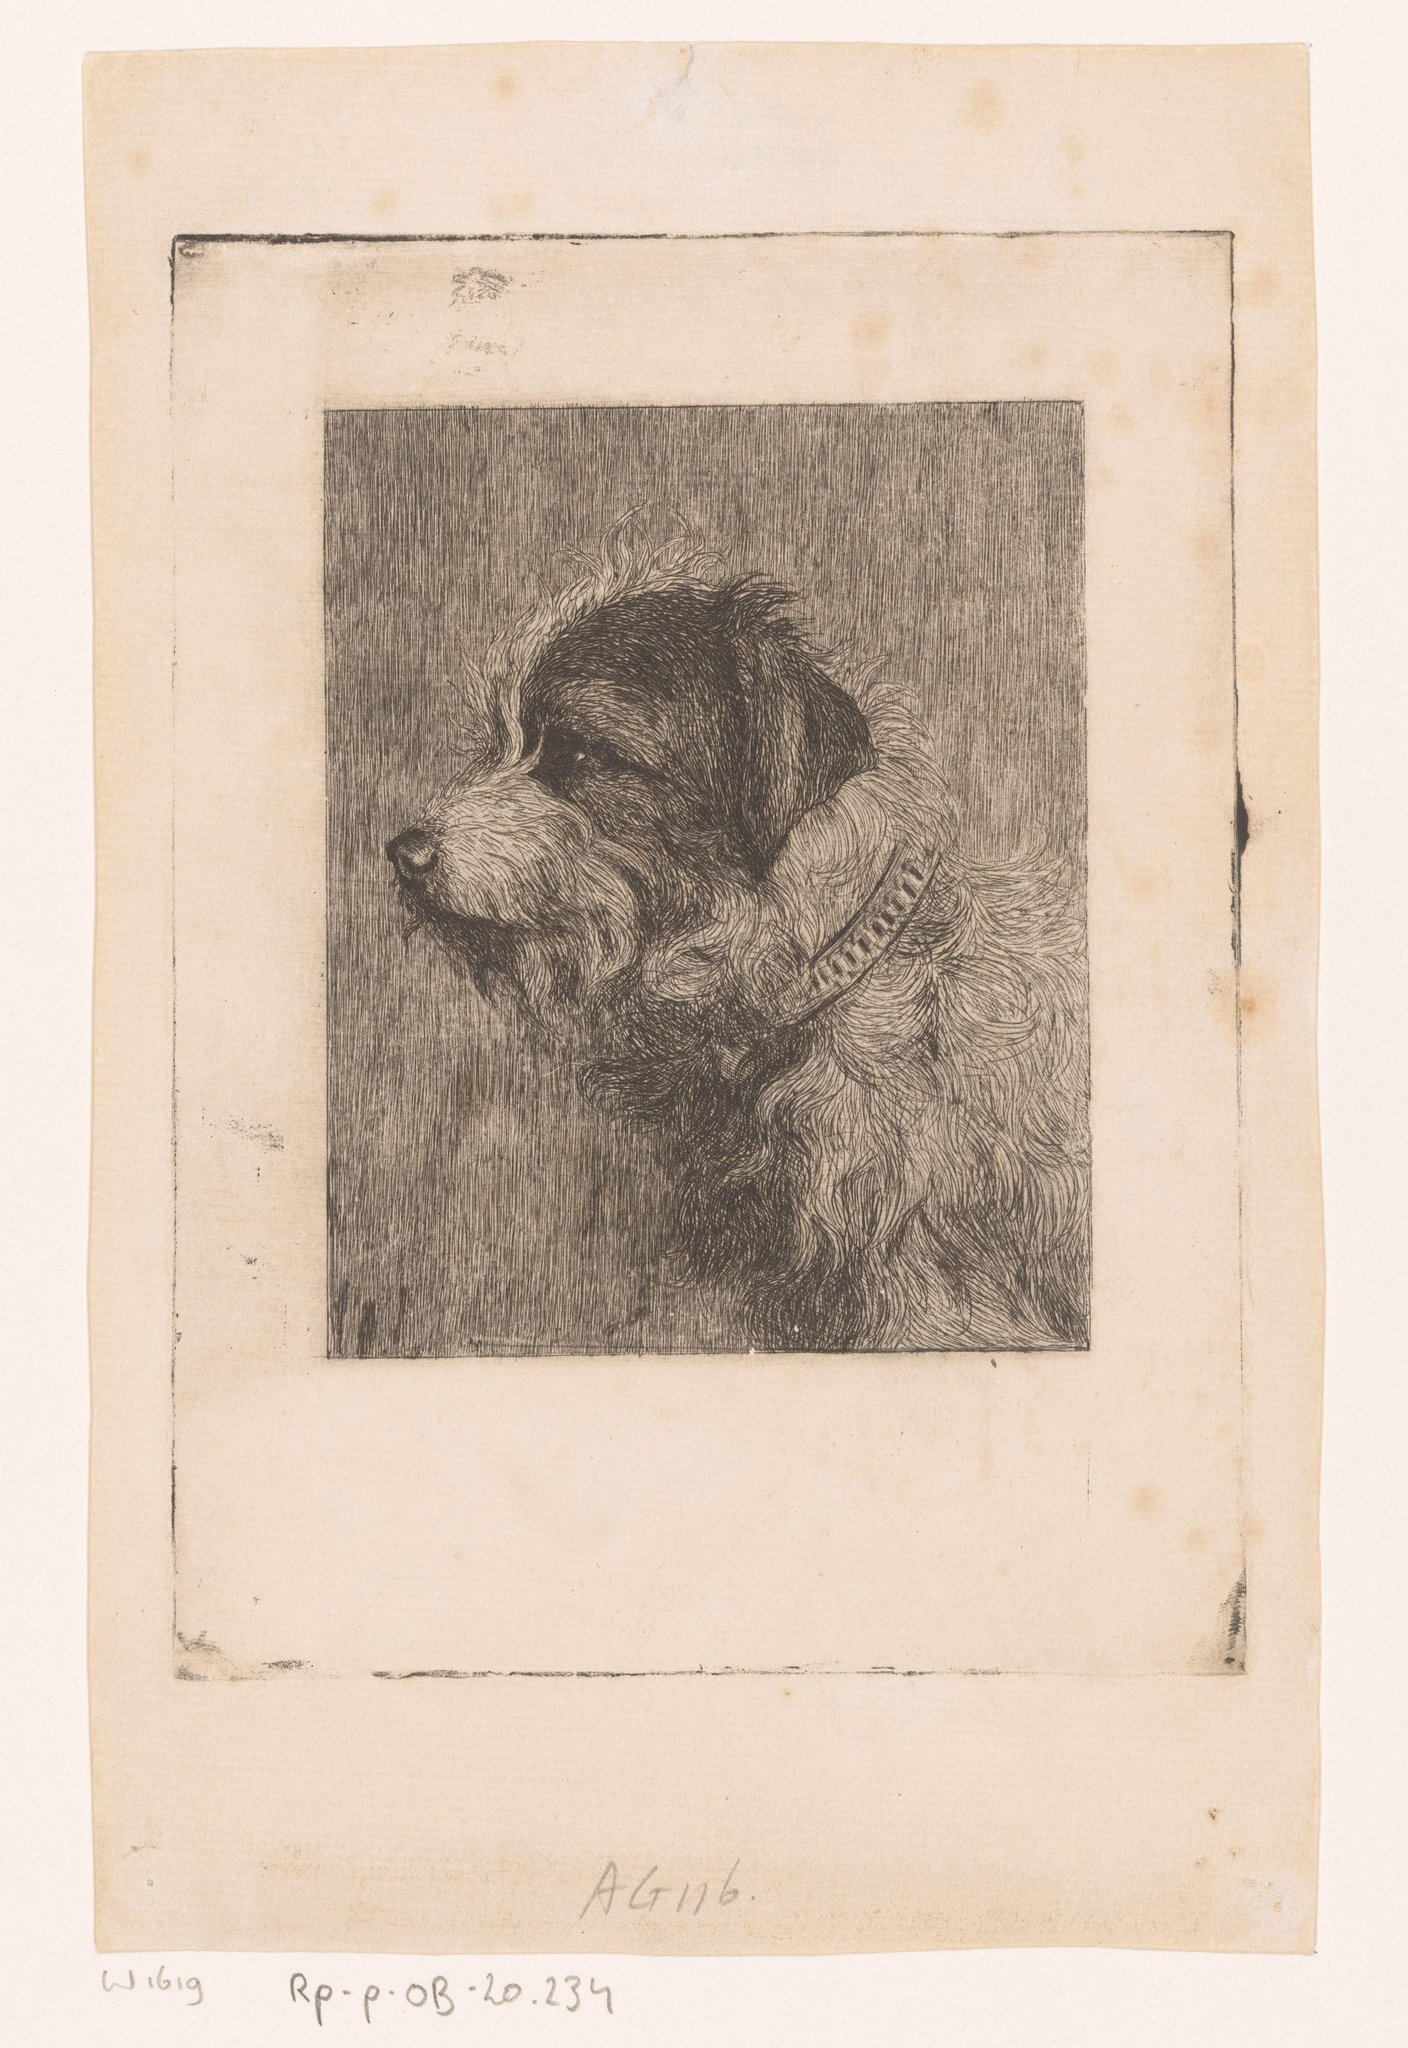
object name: print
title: Hondenkop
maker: Anonymous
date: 1850-1949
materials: paper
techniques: etching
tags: dog (+ head of an animal)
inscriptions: annotation: ‘W1619/ D.U.R.K./ W.H. 58’